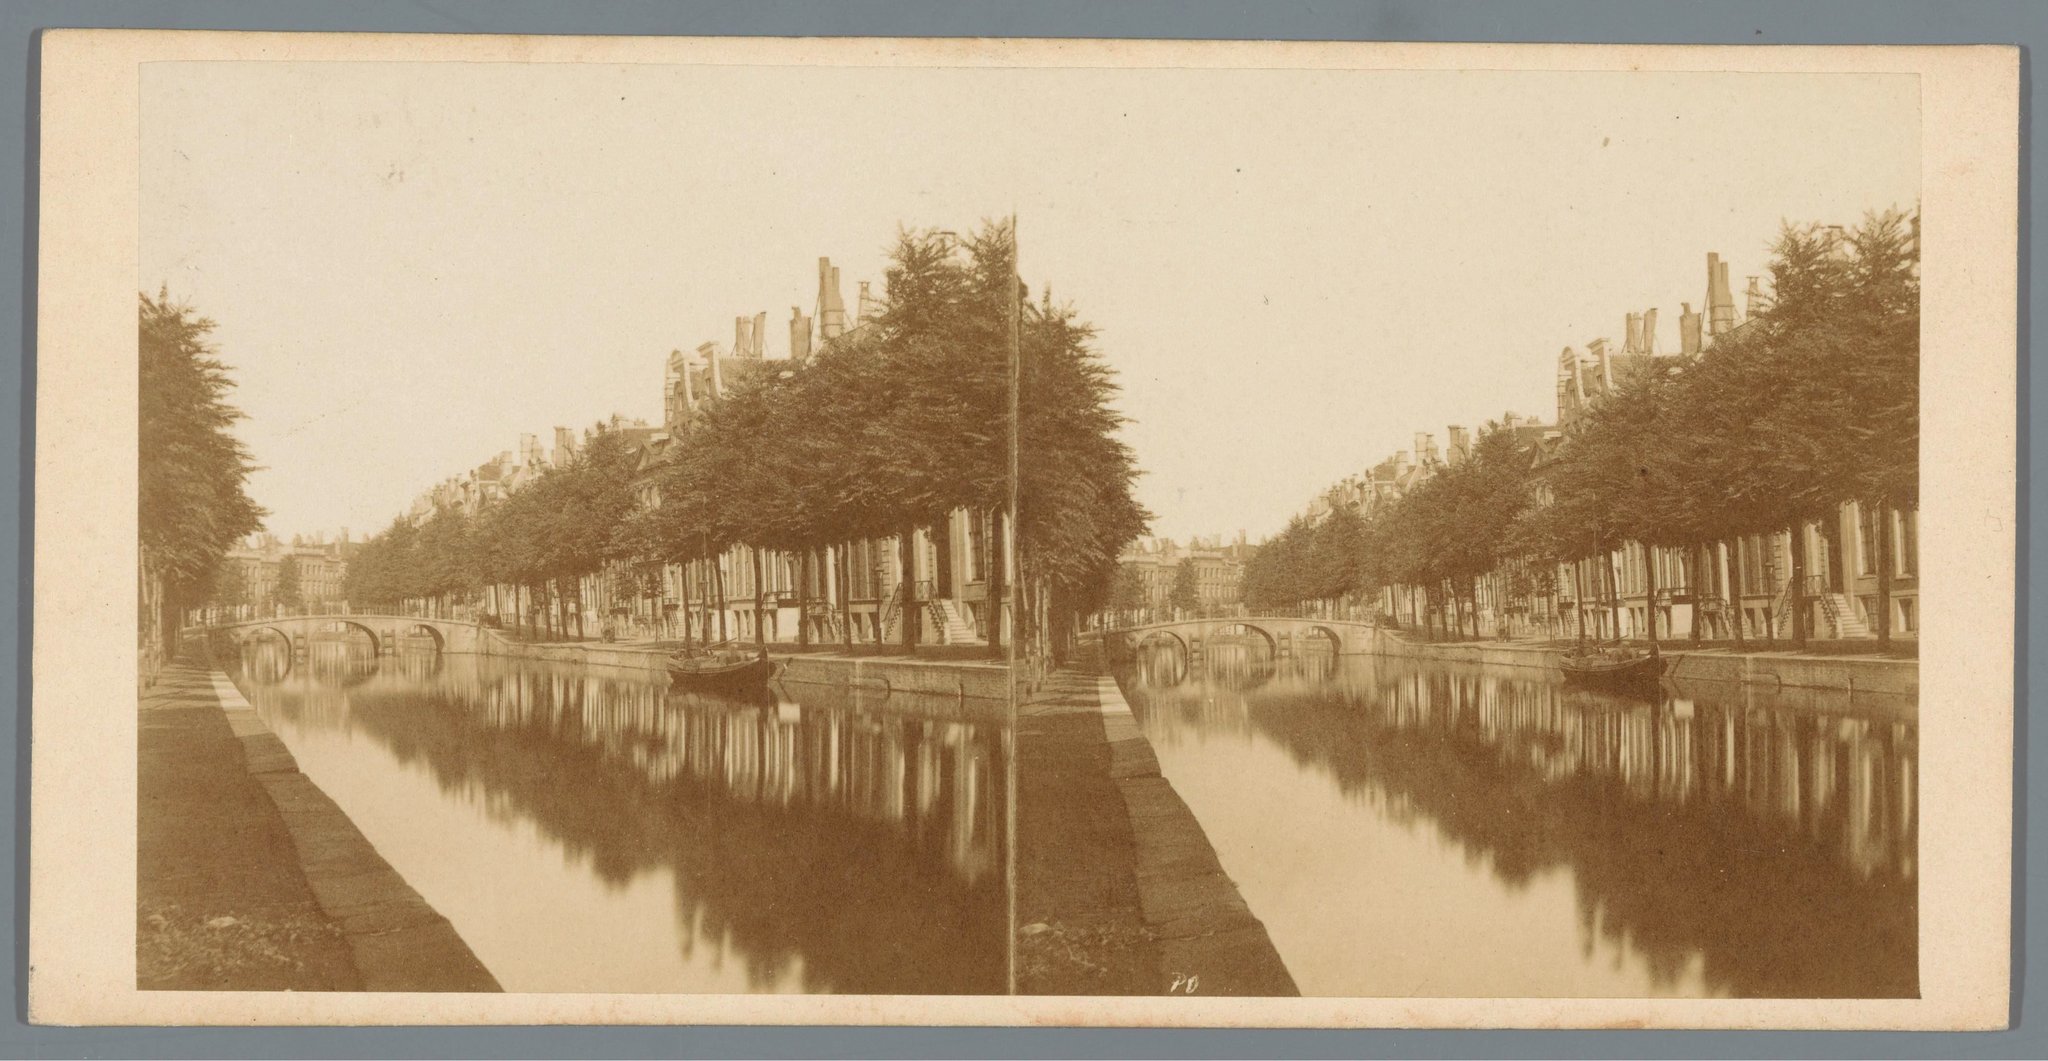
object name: stereograph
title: Heerengracht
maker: pieter oosterhuis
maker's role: draughtsman, print maker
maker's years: 1816-1885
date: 1855-1870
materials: cardboard, paper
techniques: albumen print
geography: amsterdam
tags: canals, waters (in city)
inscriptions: initials: ‘P.O.’, inscription: ‘gesigneerd P(ieter) O(osterhuis)’, number: ‘267’